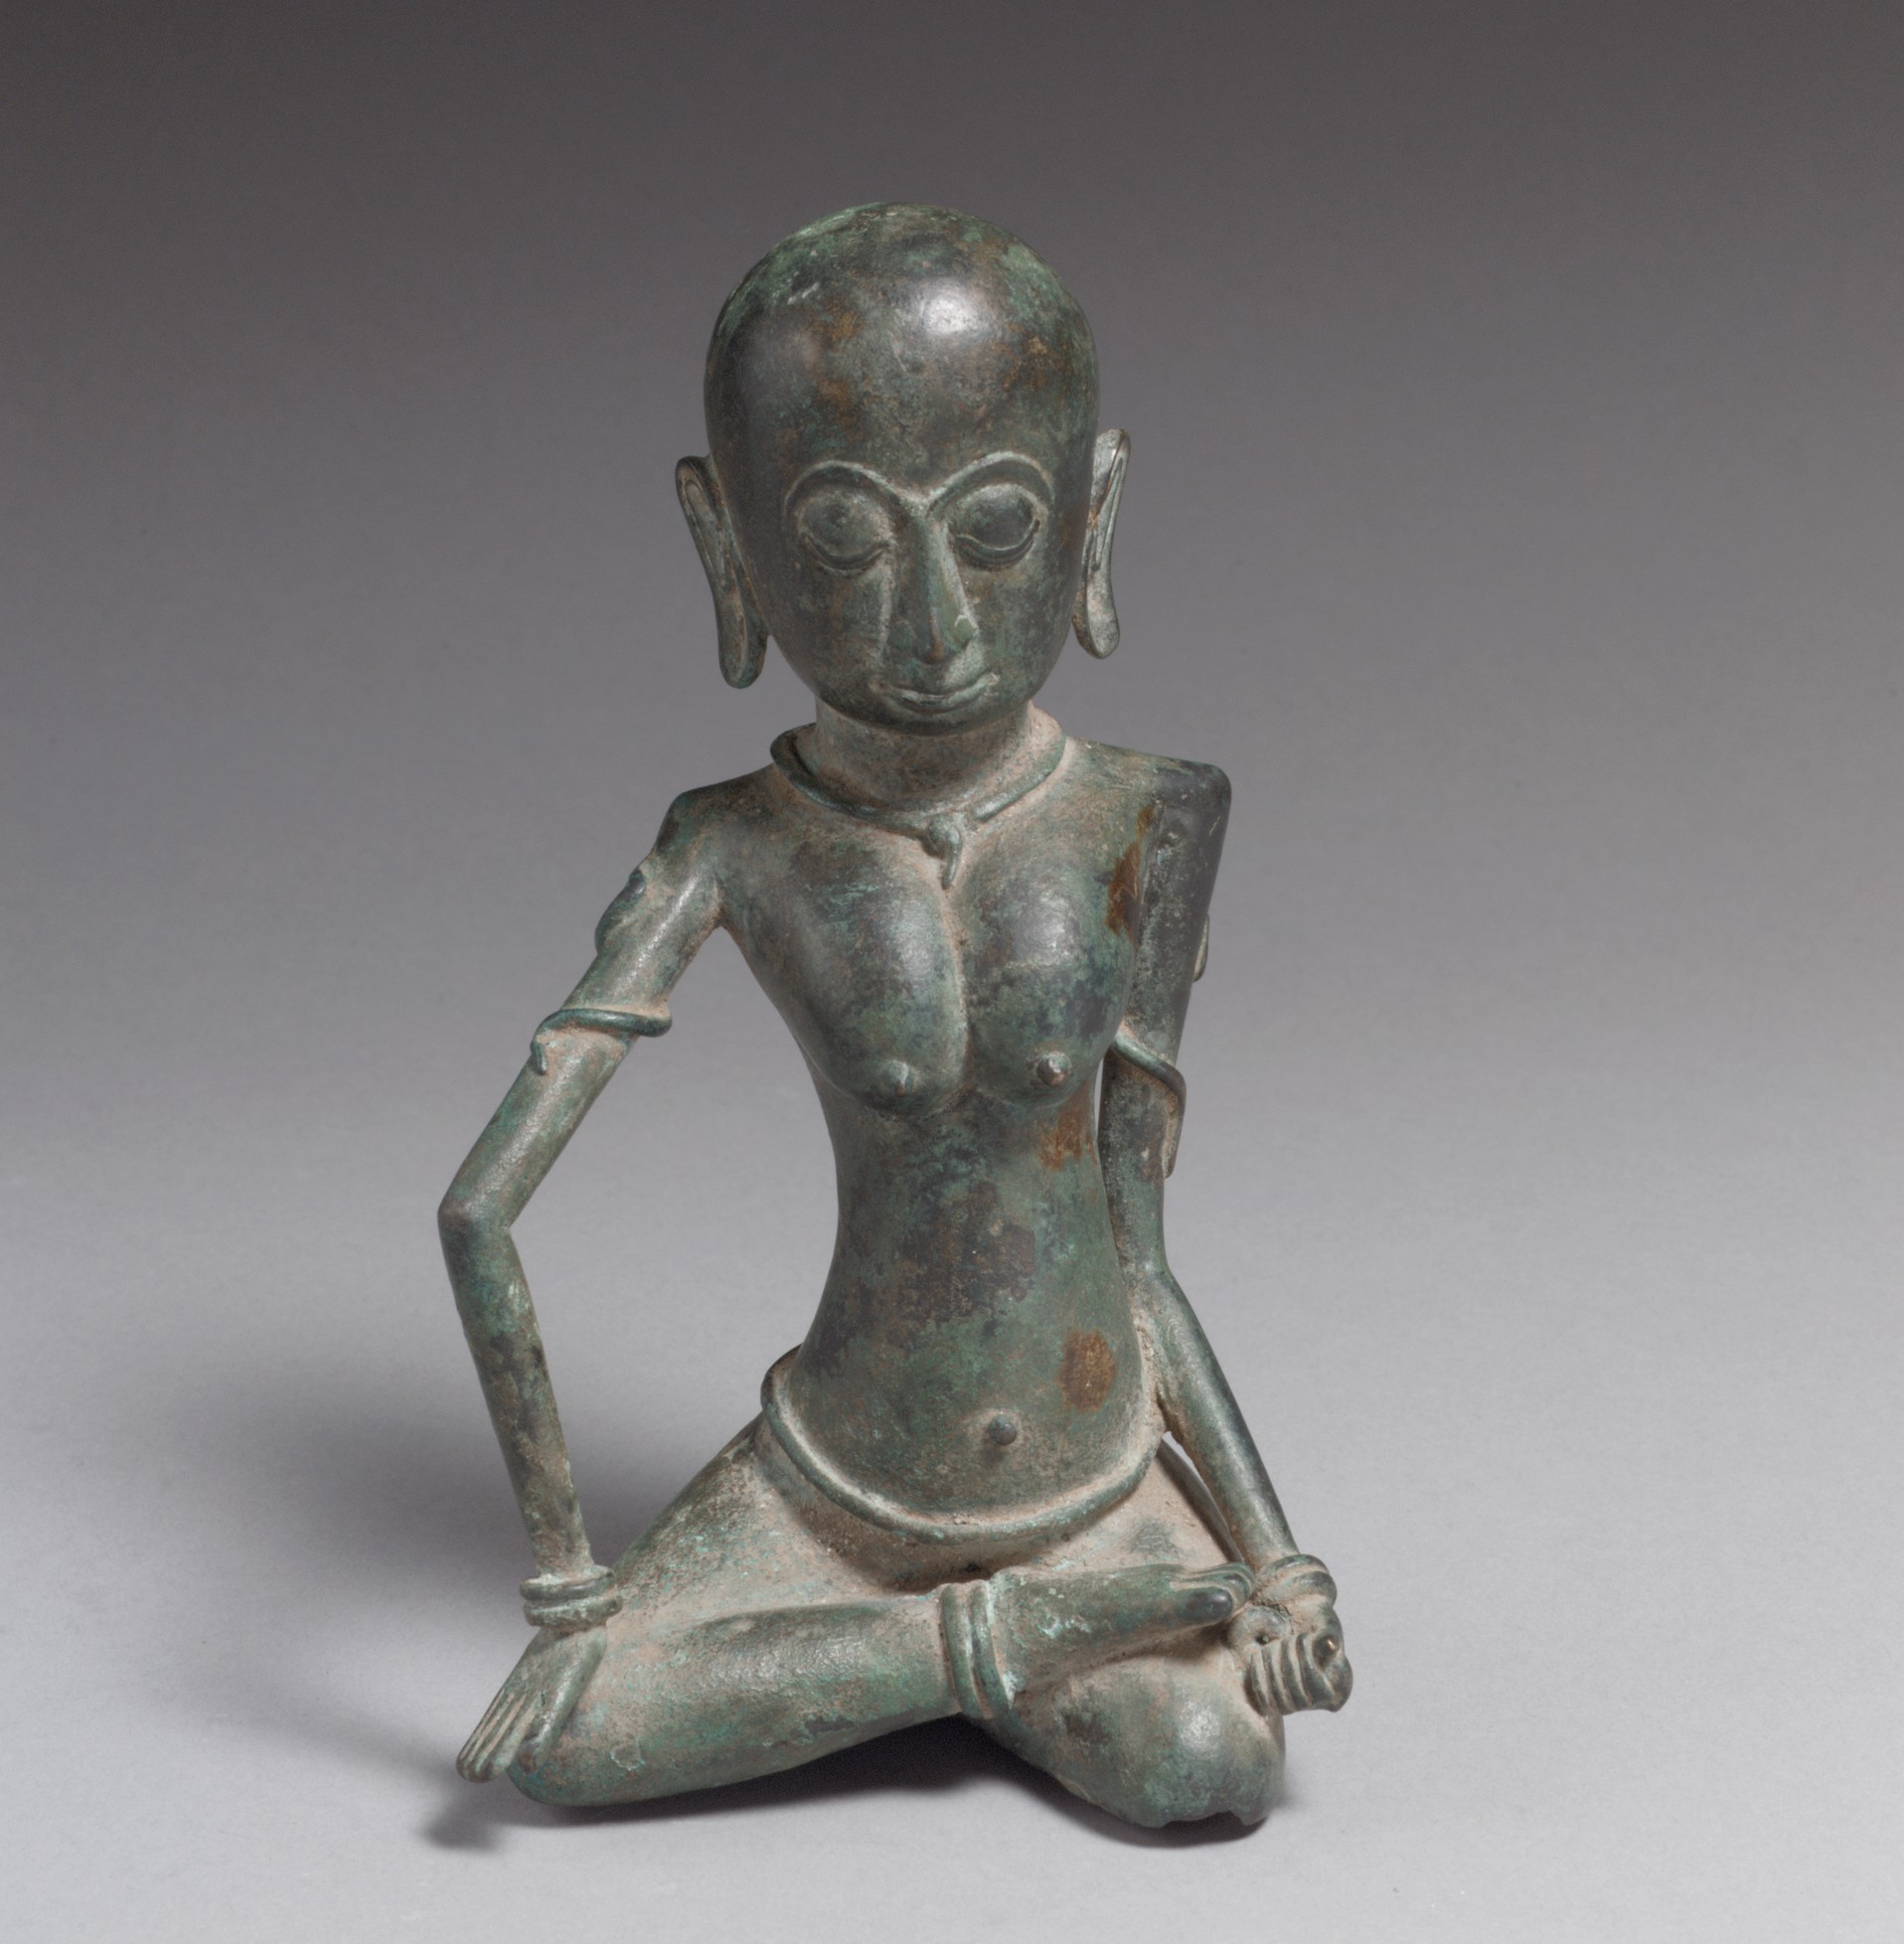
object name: figure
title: Seated Female Ascetic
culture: indonesian, javanese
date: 1401-1600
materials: bronze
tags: women